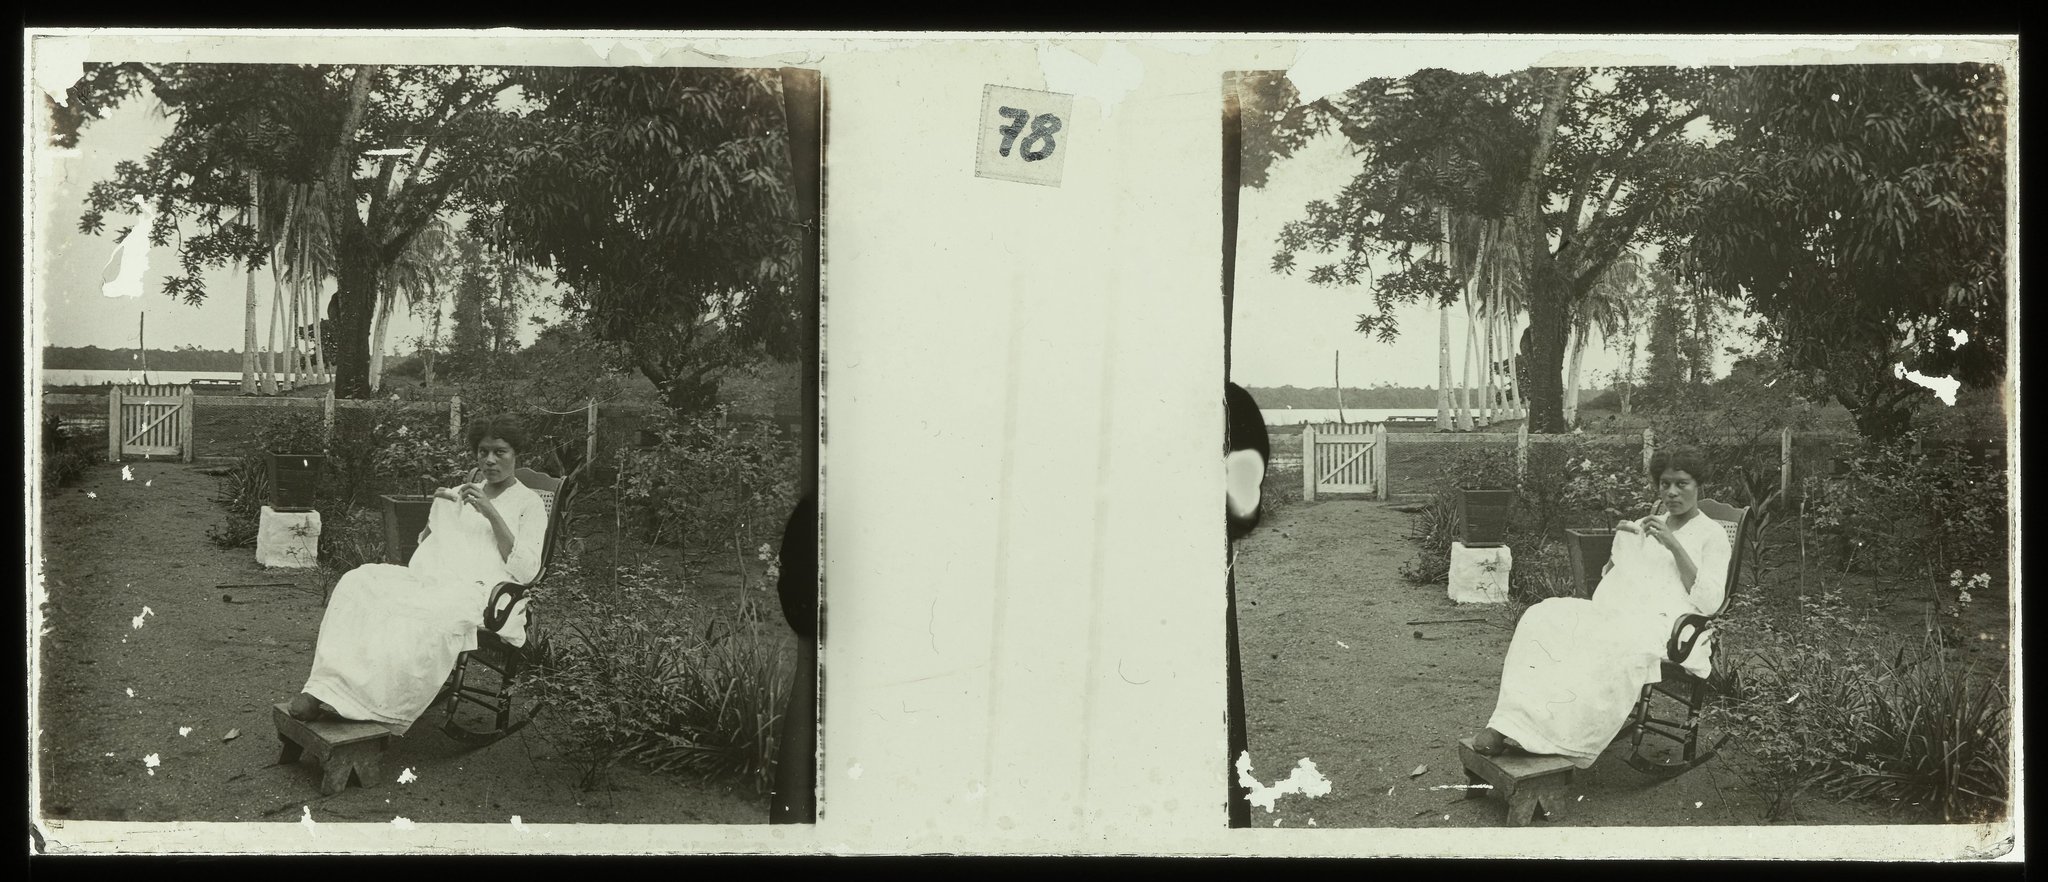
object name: stereograph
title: Lize Brouwers, de echtgenote van Theodoor Brouwers, op Plantage Accaribo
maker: theodoor brouwers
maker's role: amateurfotograaf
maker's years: 1874-1932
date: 1913-1930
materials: glass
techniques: photography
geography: suriname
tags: haarlem, plantation, suriname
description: In de periode 1911-1932 woonde op plantage Accaribo in Suriname de familie Brouwers van wie de foto's afkomstig zijn. Rond 1910 vond Theodoor Brouwers werk op plantage Accaribo. In 1929 werd hij eigenaar van de plantage. Op Accaribo werden in zijn tijd bananen geproduceerd en wat koffie.